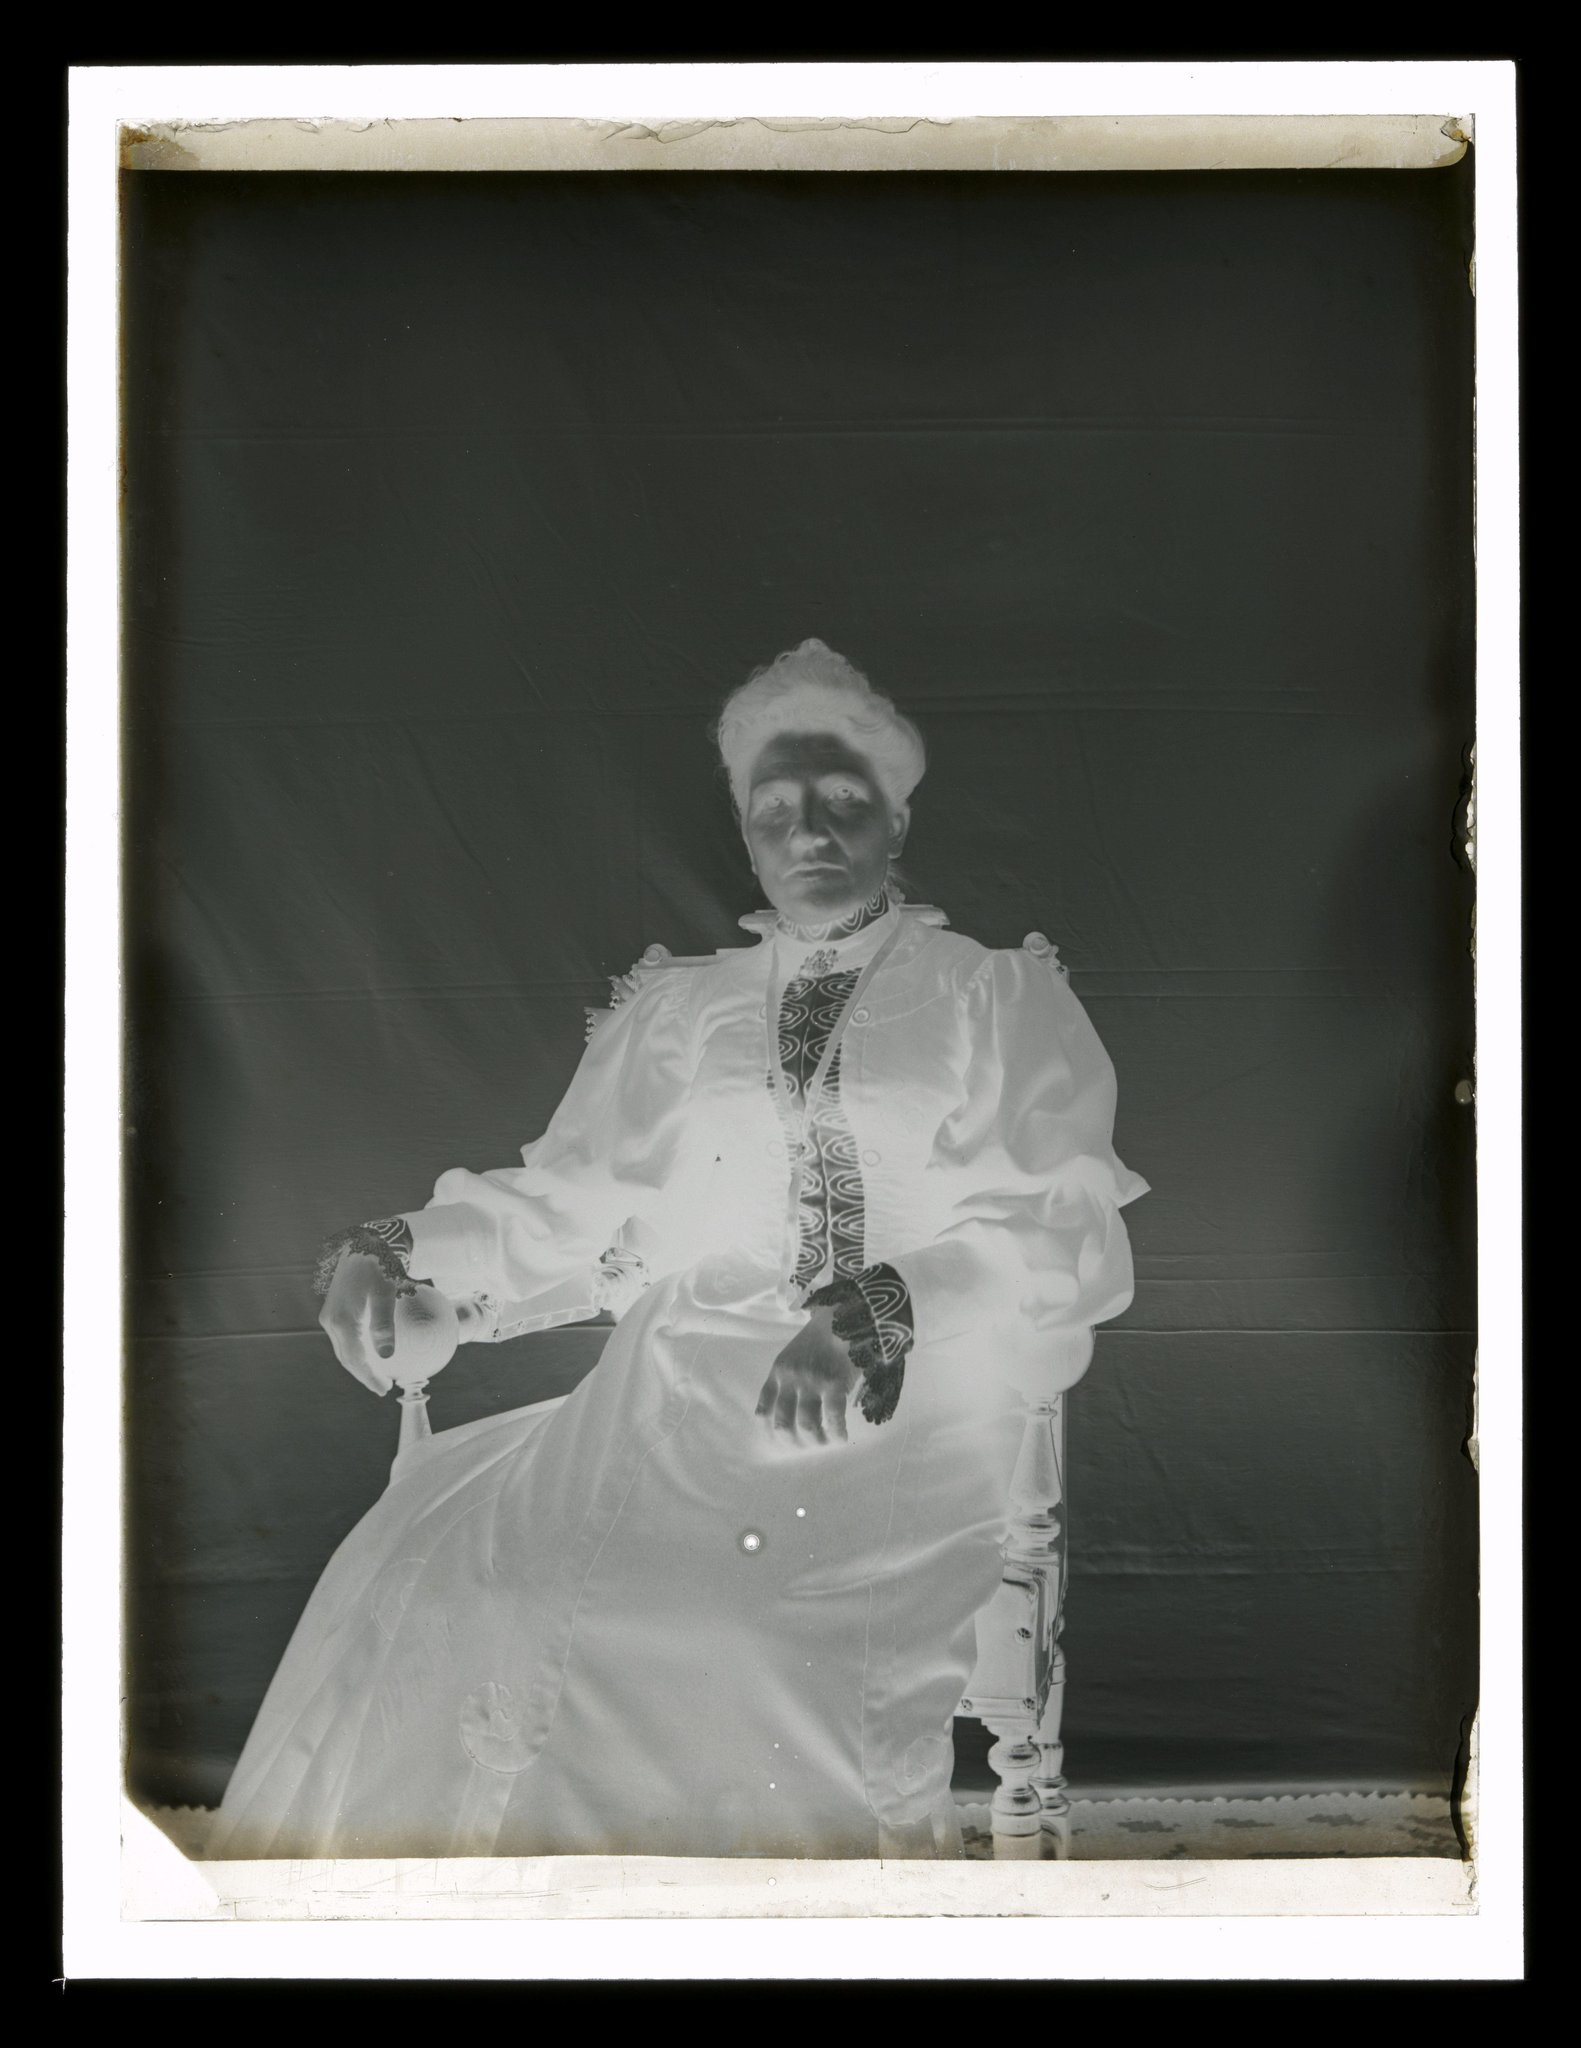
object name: photograph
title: Portret van een onbekende vrouw op een stoel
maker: Anonymous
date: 1907-1935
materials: glass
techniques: gelatin glass negative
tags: sitting figure, historical persons not known by name - bb - woman